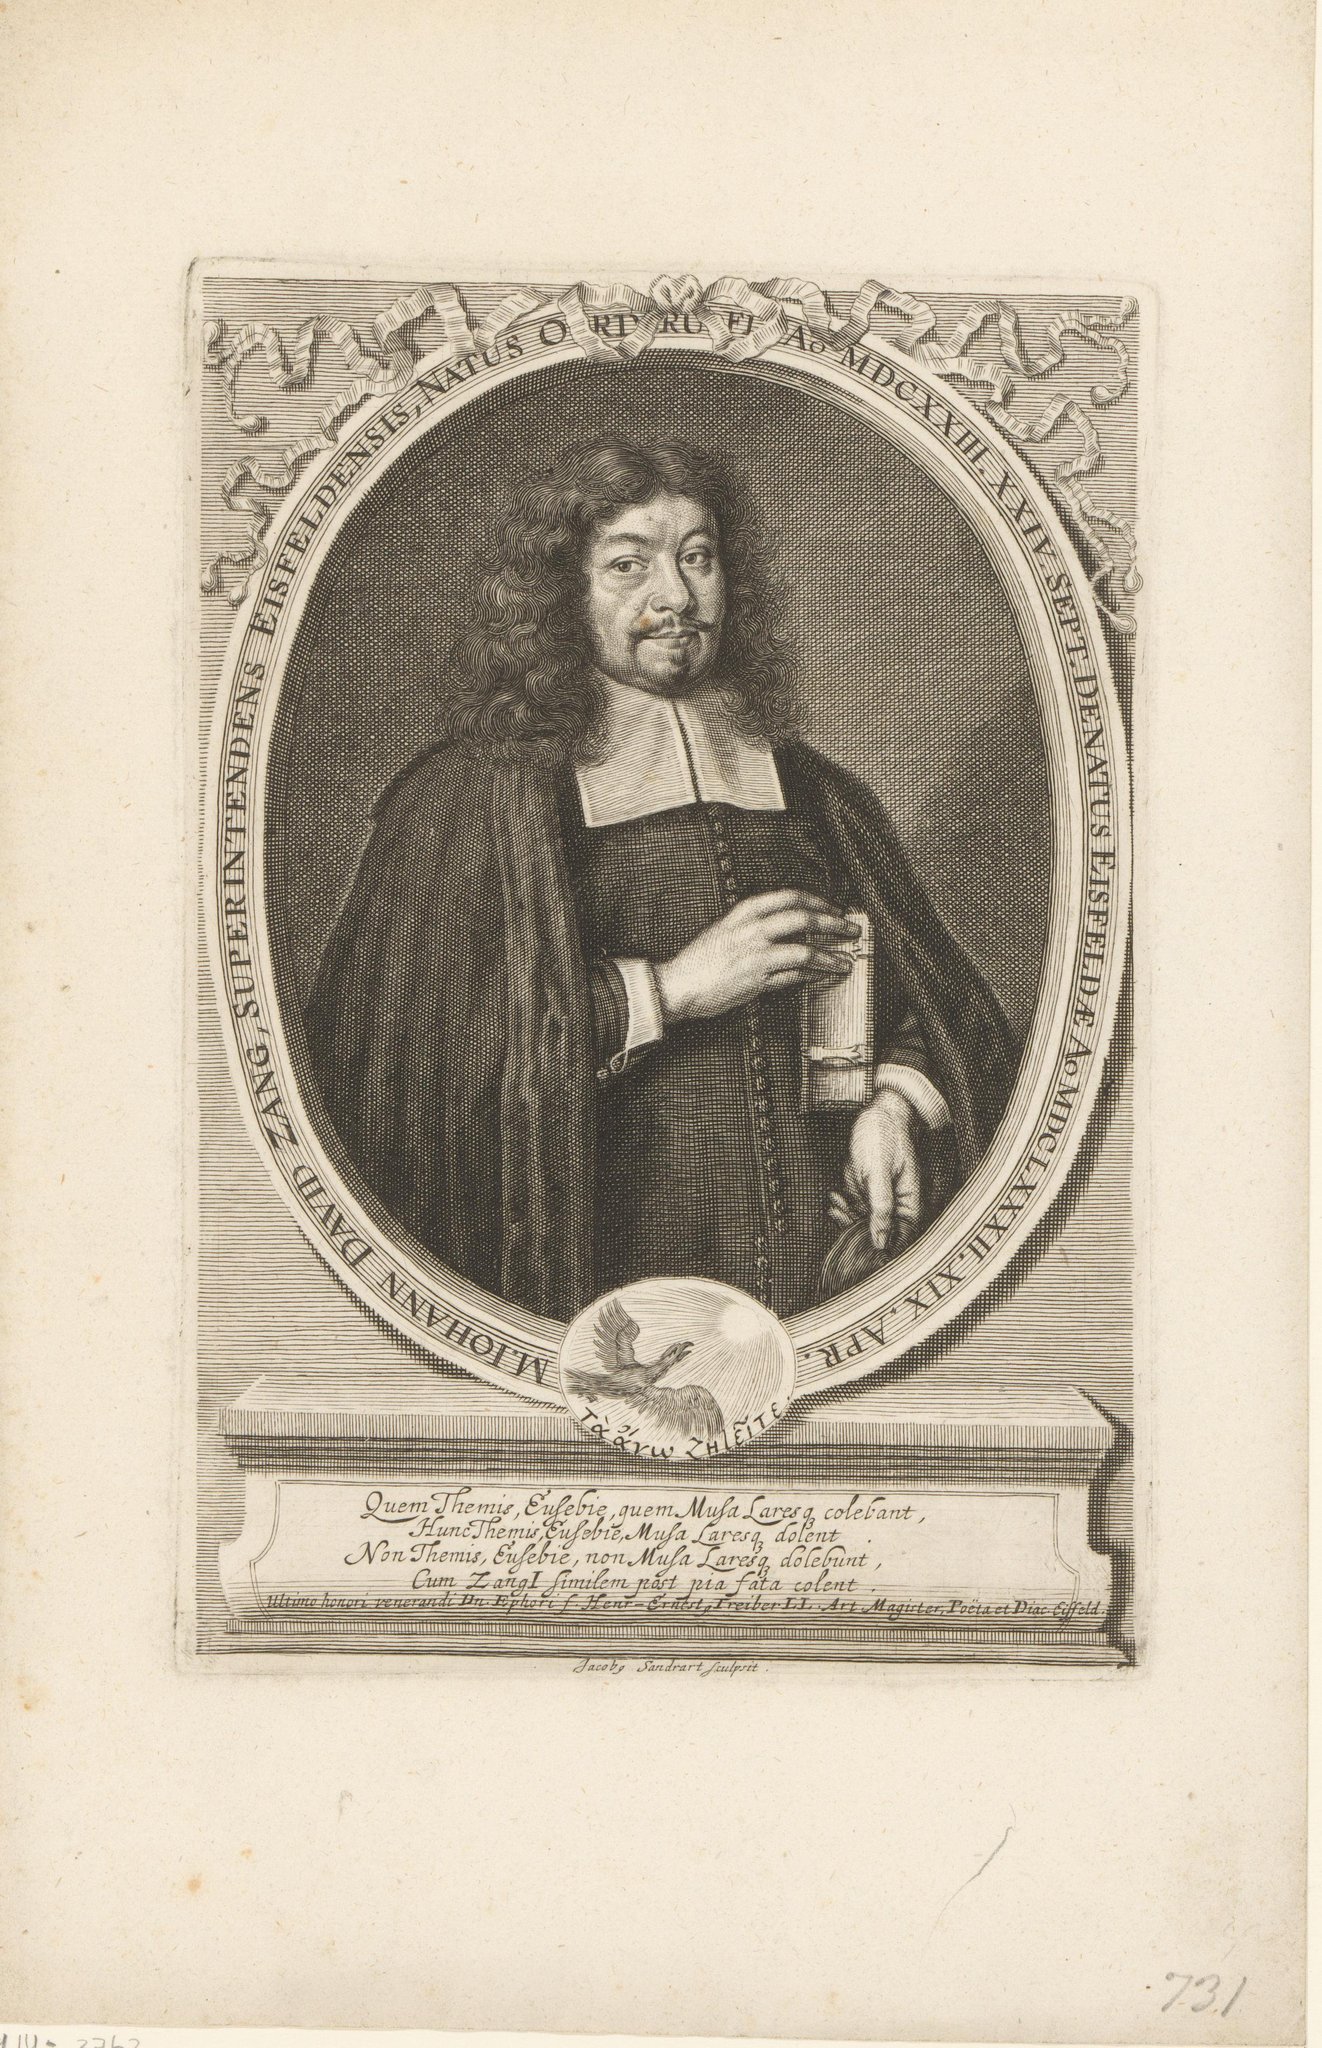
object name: print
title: Portret van Johann David Zang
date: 1683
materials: paper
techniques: engraving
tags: priest, theologian, historical persons, book, abstract ideas and concepts (+ emblematical representation of concept)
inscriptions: collector's mark: Lugt 2228